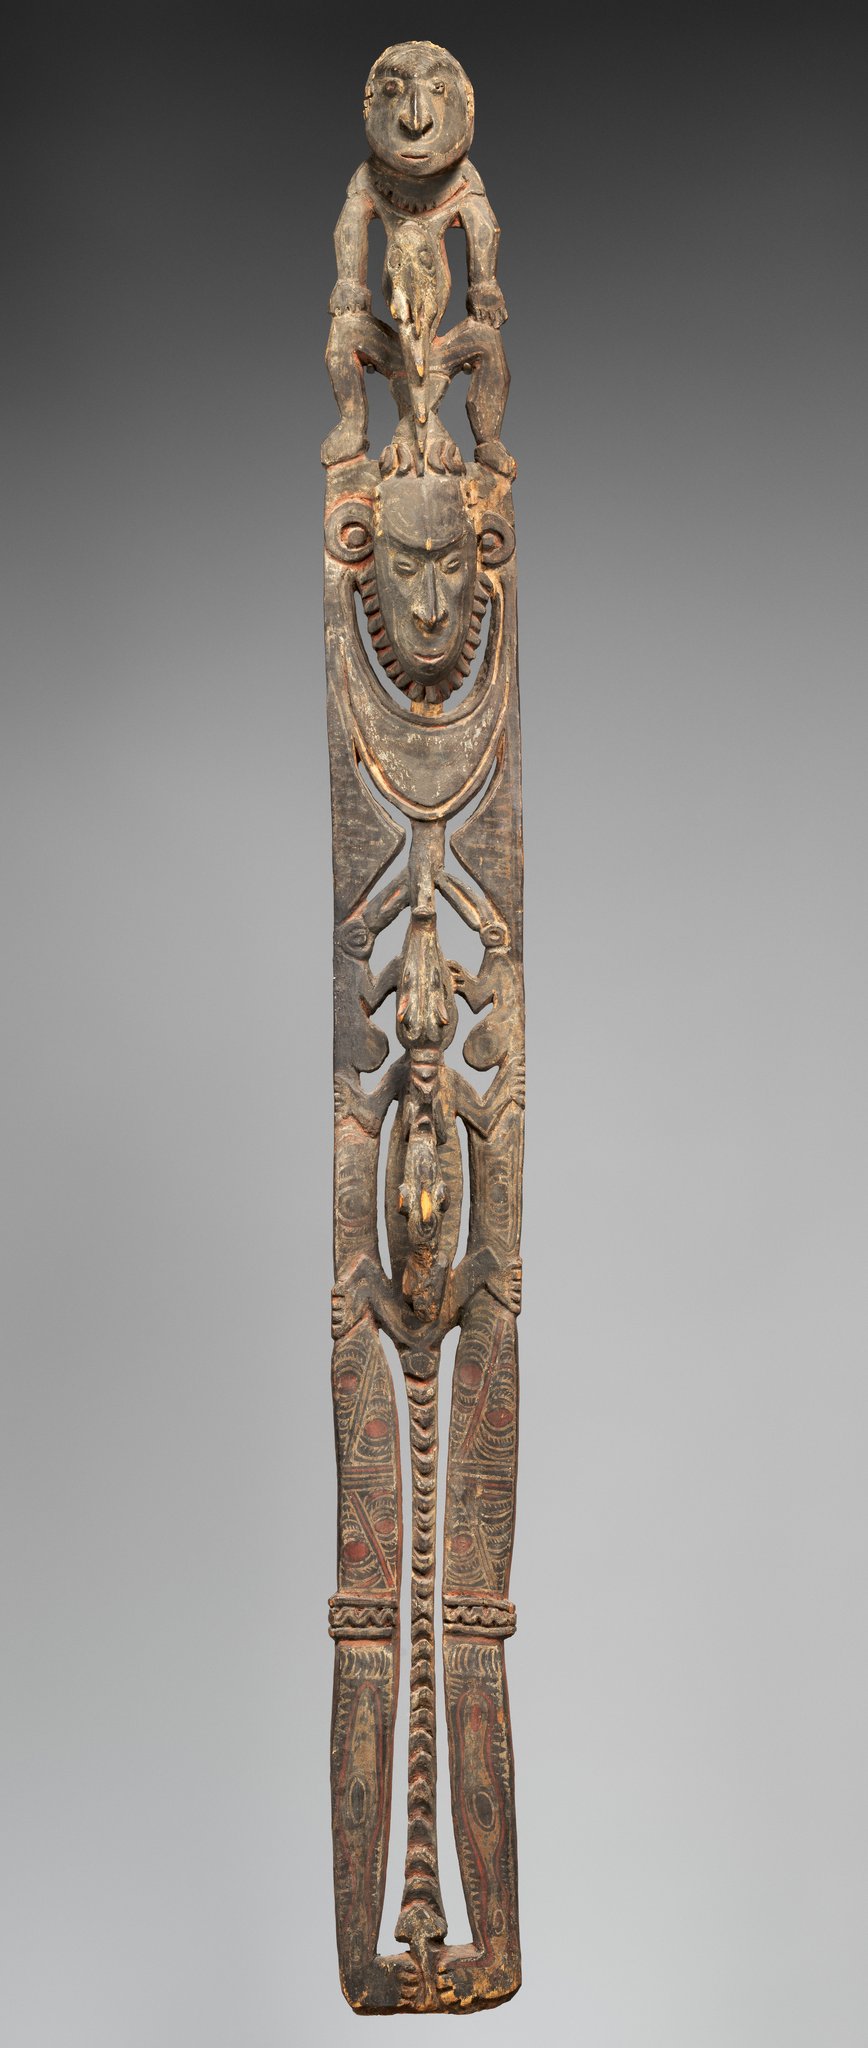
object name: figure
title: Ancestor Figure (Konumb or Atei)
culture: angoram people or kopar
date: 1801-1900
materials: paint, wood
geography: papua new guinea